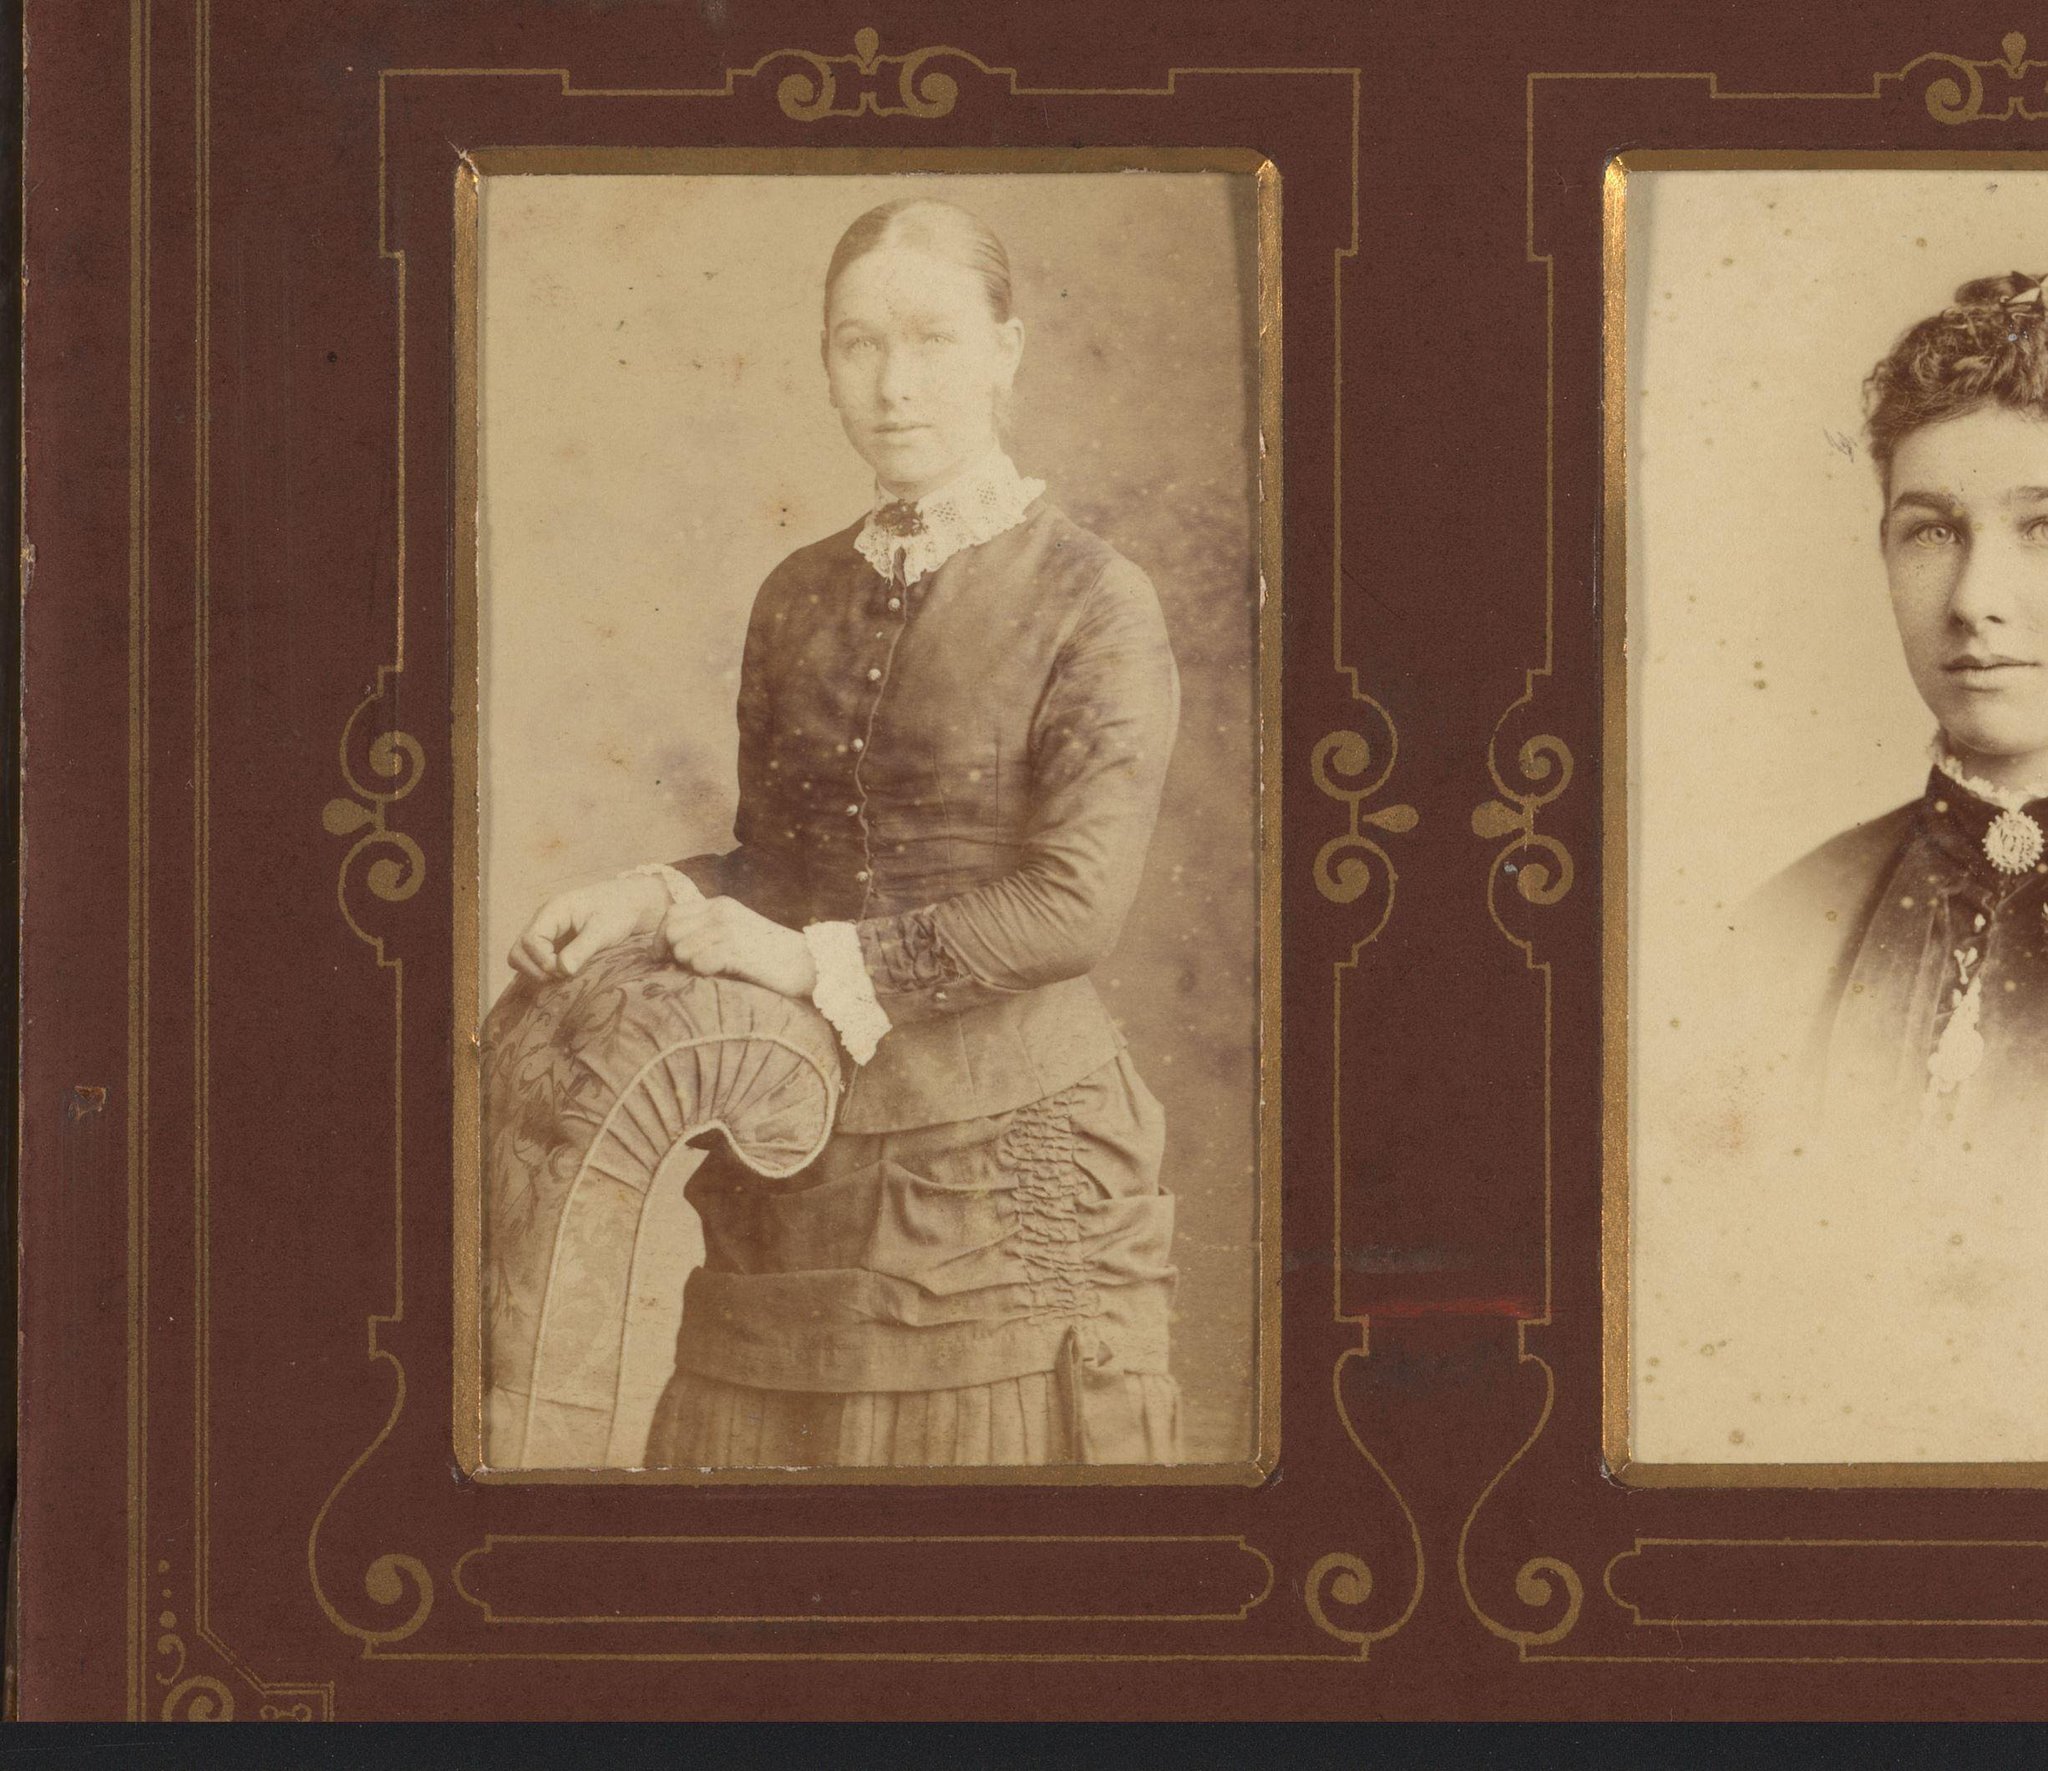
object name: photograph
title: Portret van een vrouw, staand bij een stoel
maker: w.s. spanton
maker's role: fotograaf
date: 1864-1870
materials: cardboard, photographic support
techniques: albumen print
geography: bury saint edmunds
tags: historical persons - bb - woman, standing figure - aa - female human figure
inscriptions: inscription: ‘W.S. Spanton/ Photographer/ Abbey Gate Street/ Bury St. Edmunds’